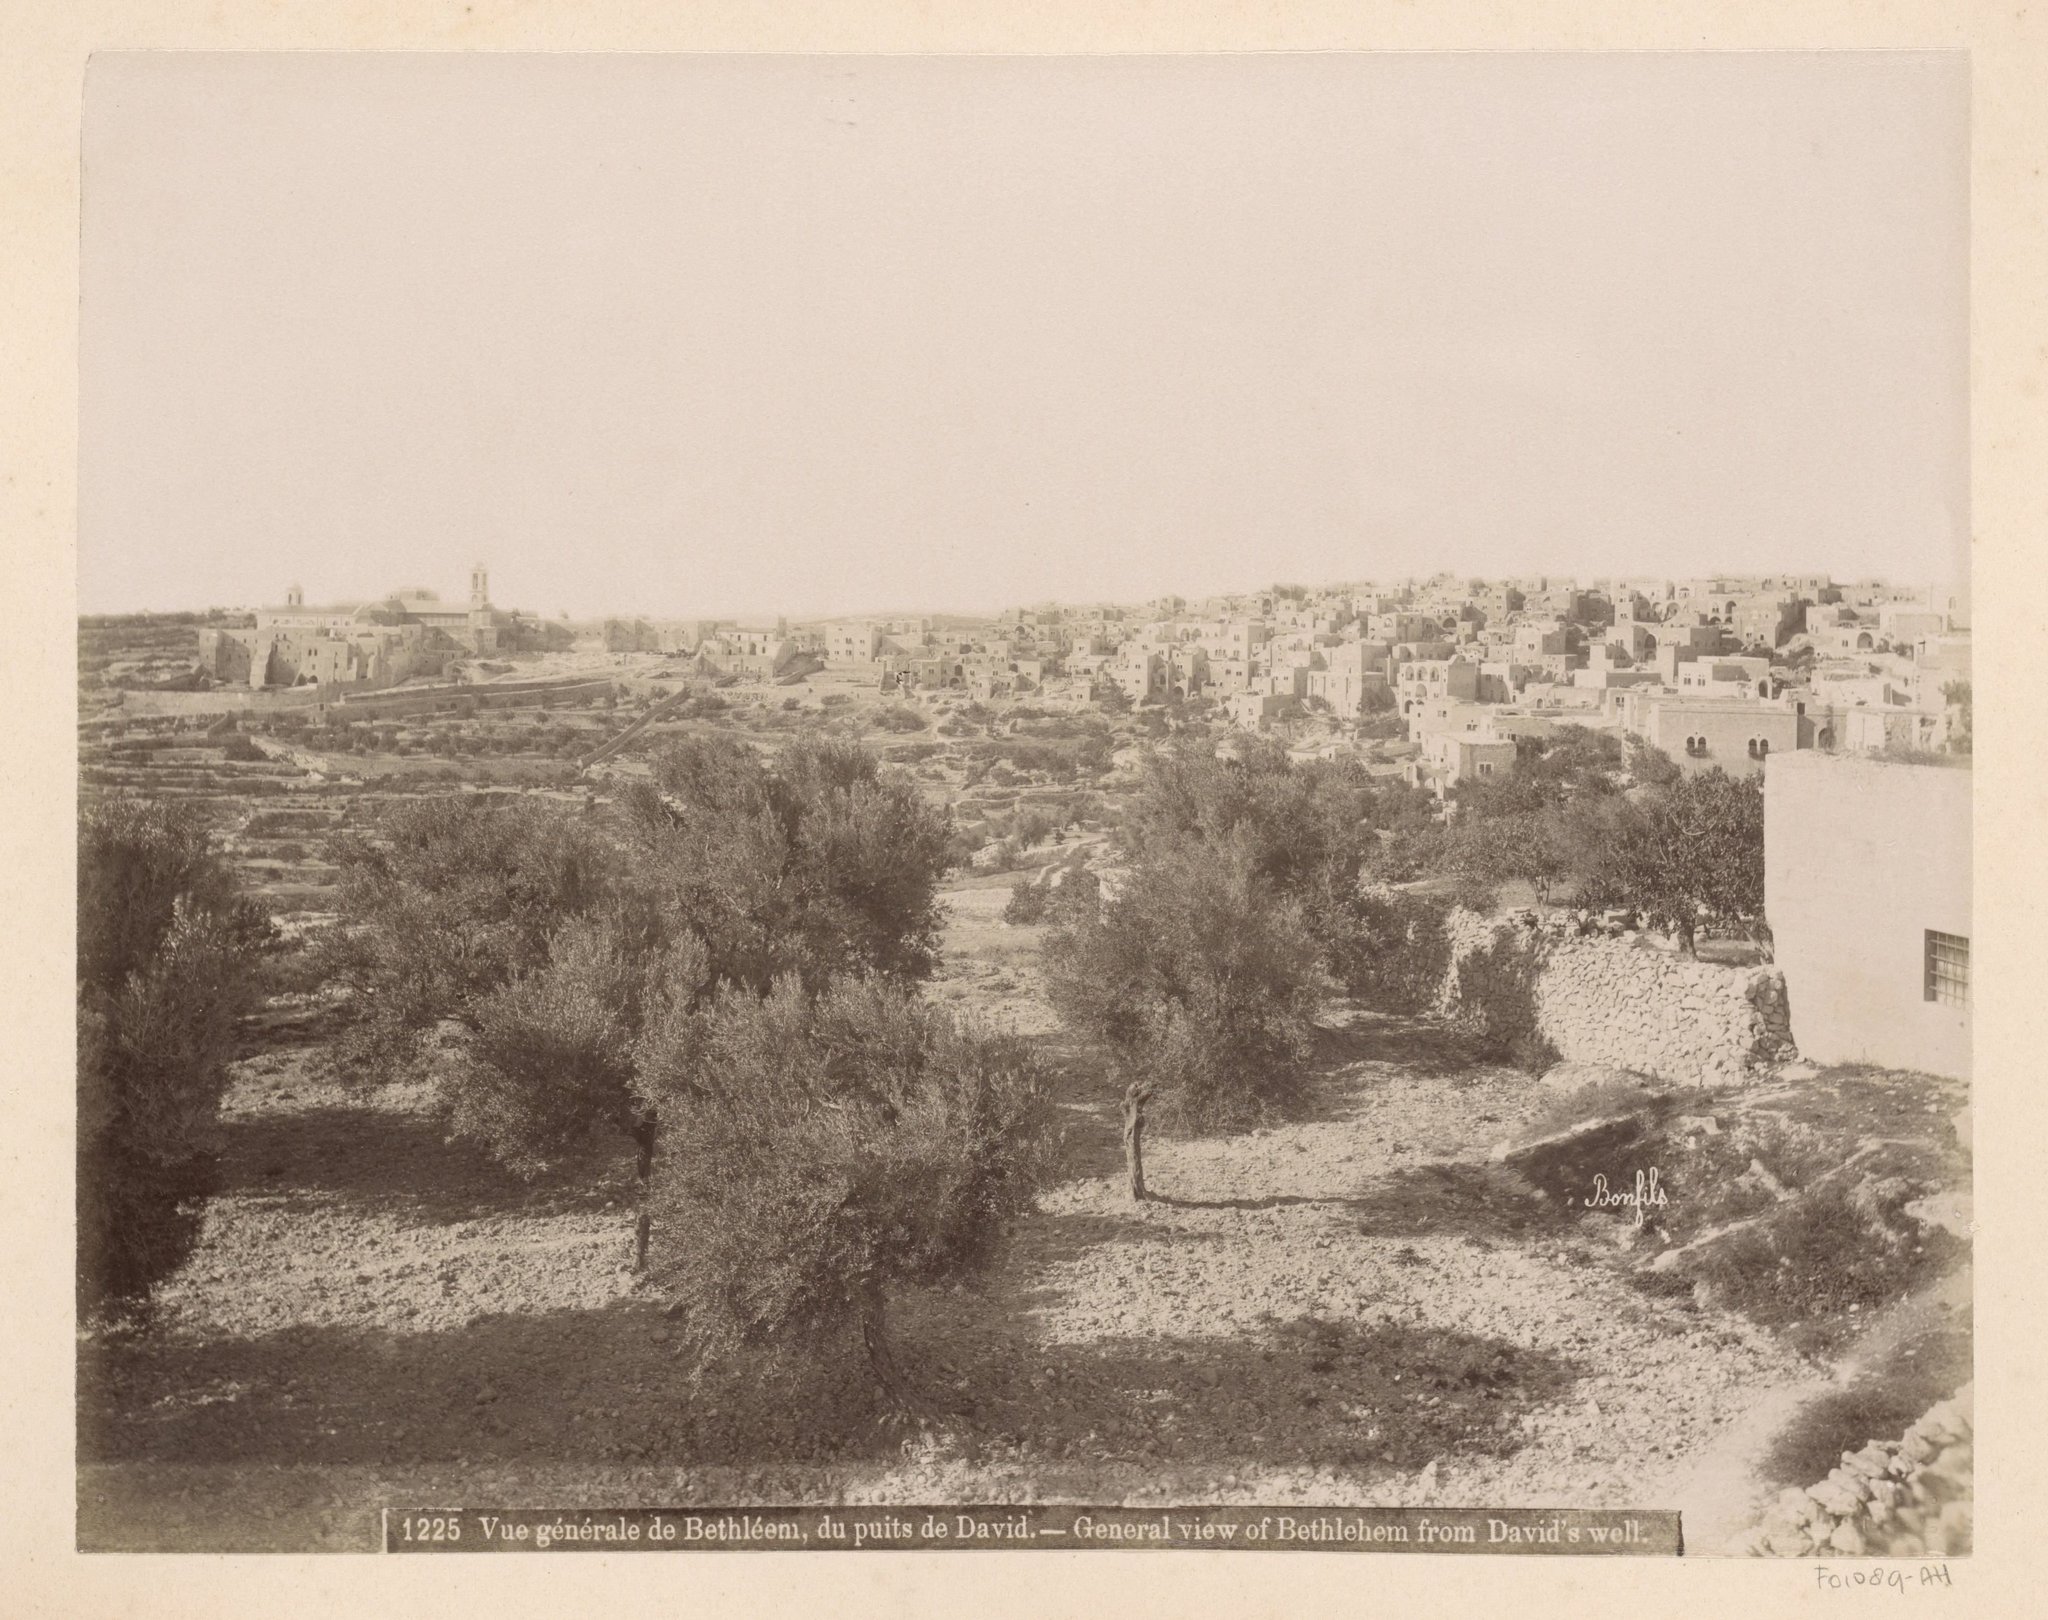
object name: photograph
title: Vue générale de Bethléem, du puits de David. - General view of Bethlehem from David's well.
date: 1867-1895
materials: cardboard, paper, photographic support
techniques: albumen print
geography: bethlehem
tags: prospect of village, silhouette of village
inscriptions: negative number: ‘1225’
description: Onderdeel van Reisalbum met foto's van Jeruzalem en andere bijbelse plaatsen.